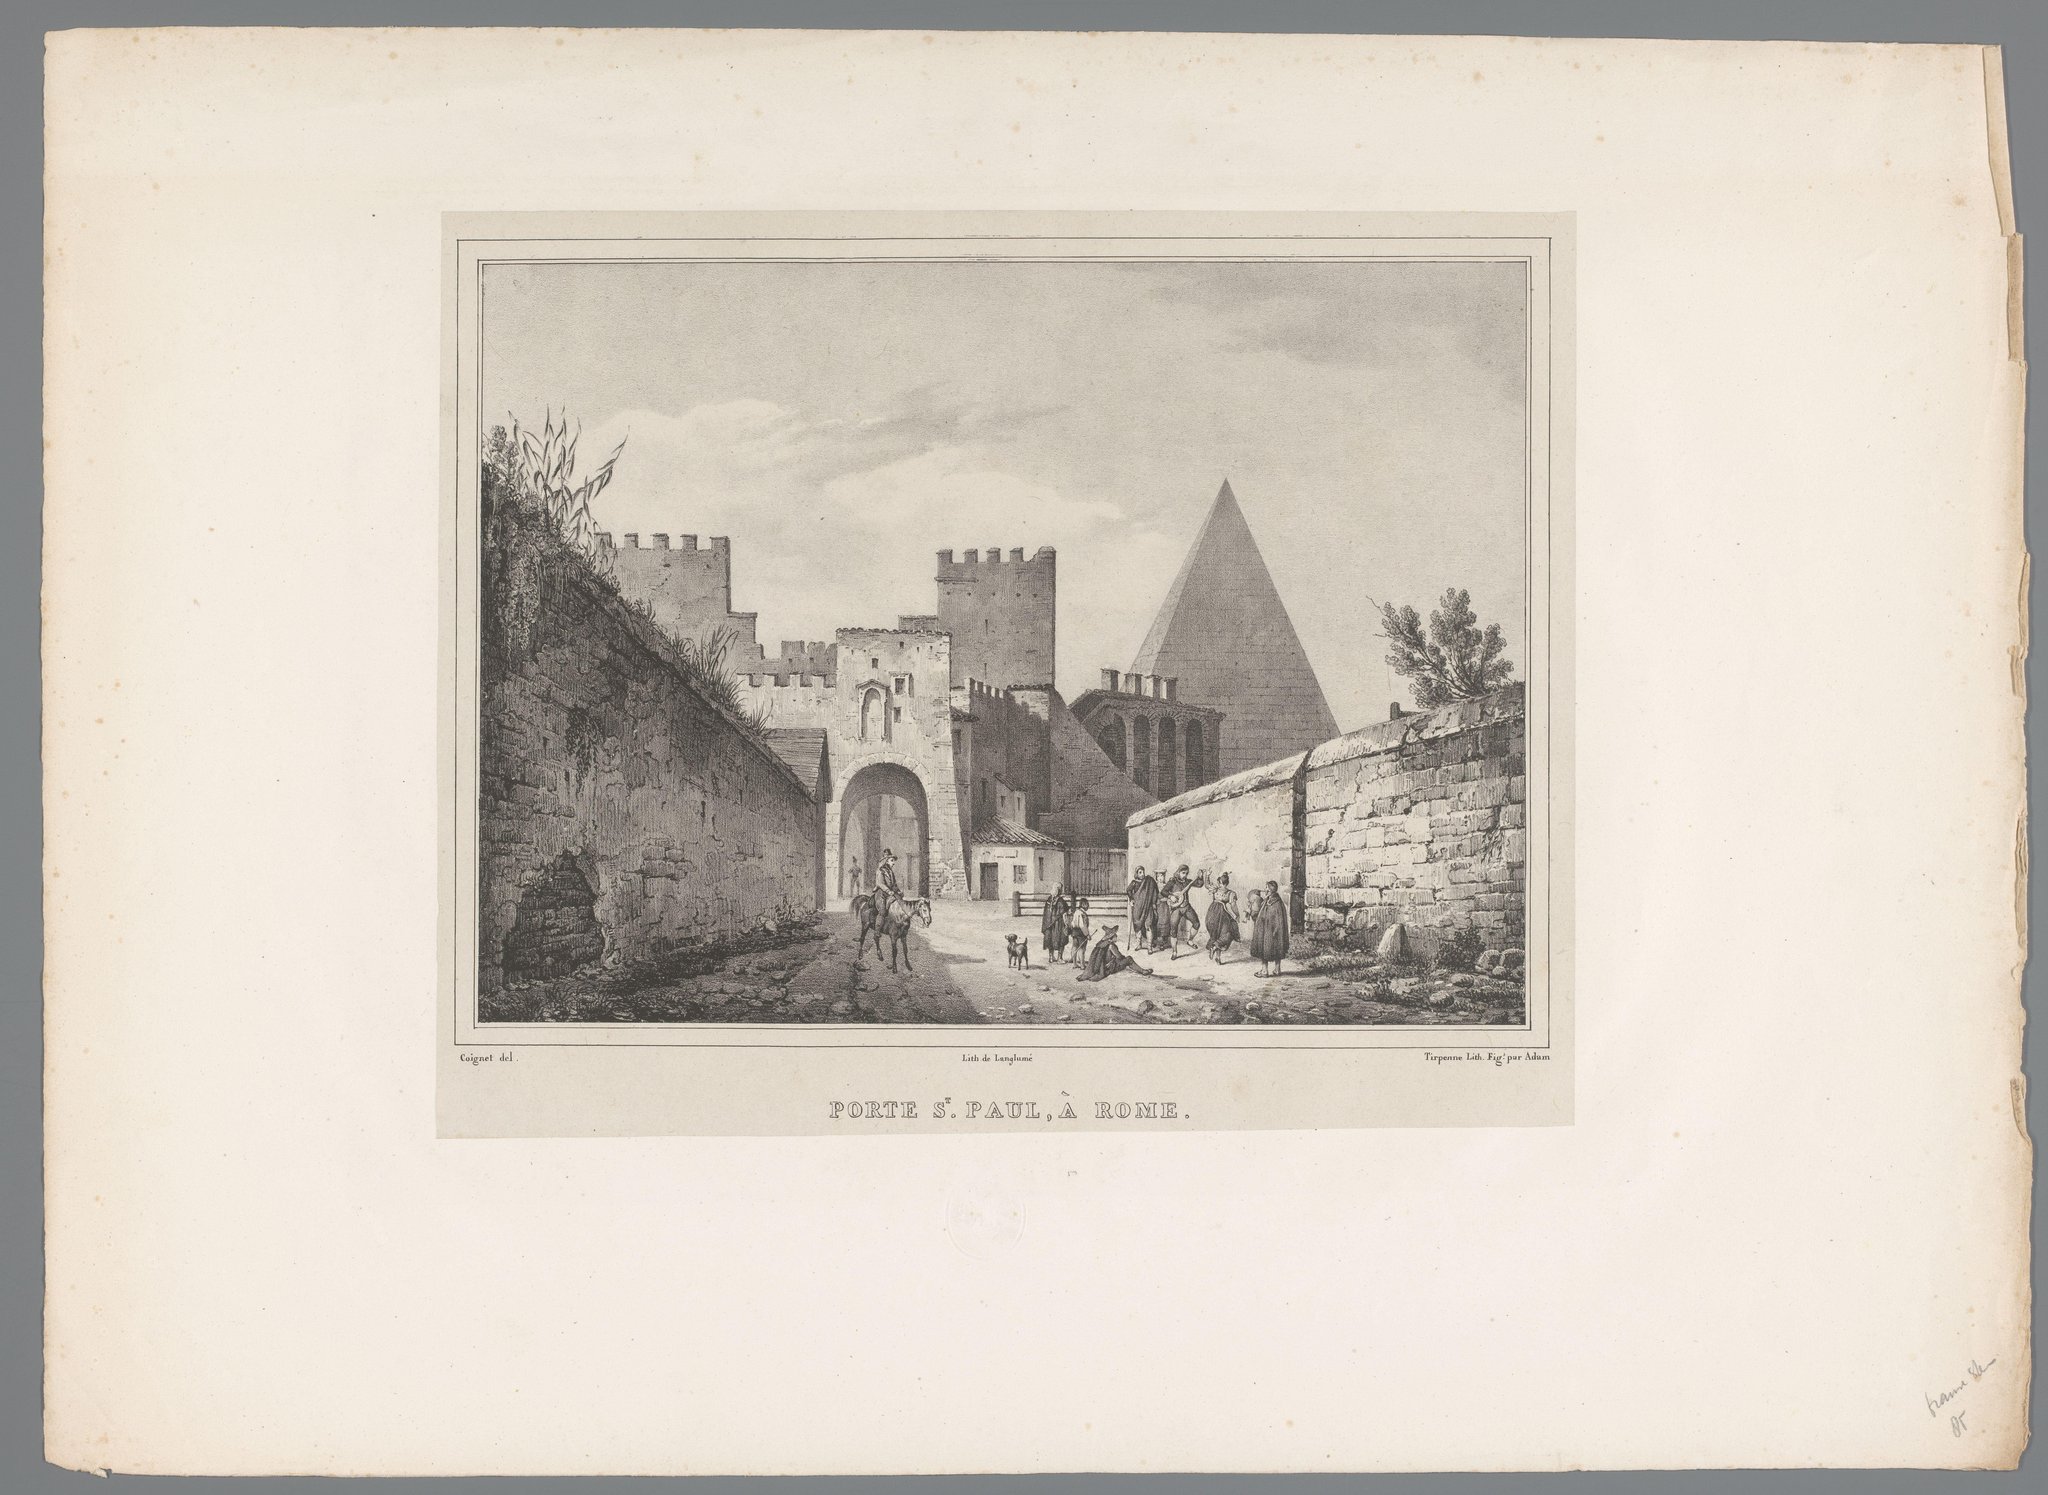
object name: print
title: Porte St. Paul, à Rome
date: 1842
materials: paper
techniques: lithograph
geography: paris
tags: street (+ city(-scape) with figures, staffage)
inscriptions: collector's mark: Lugt 2228, check stamp: Lugt 3431